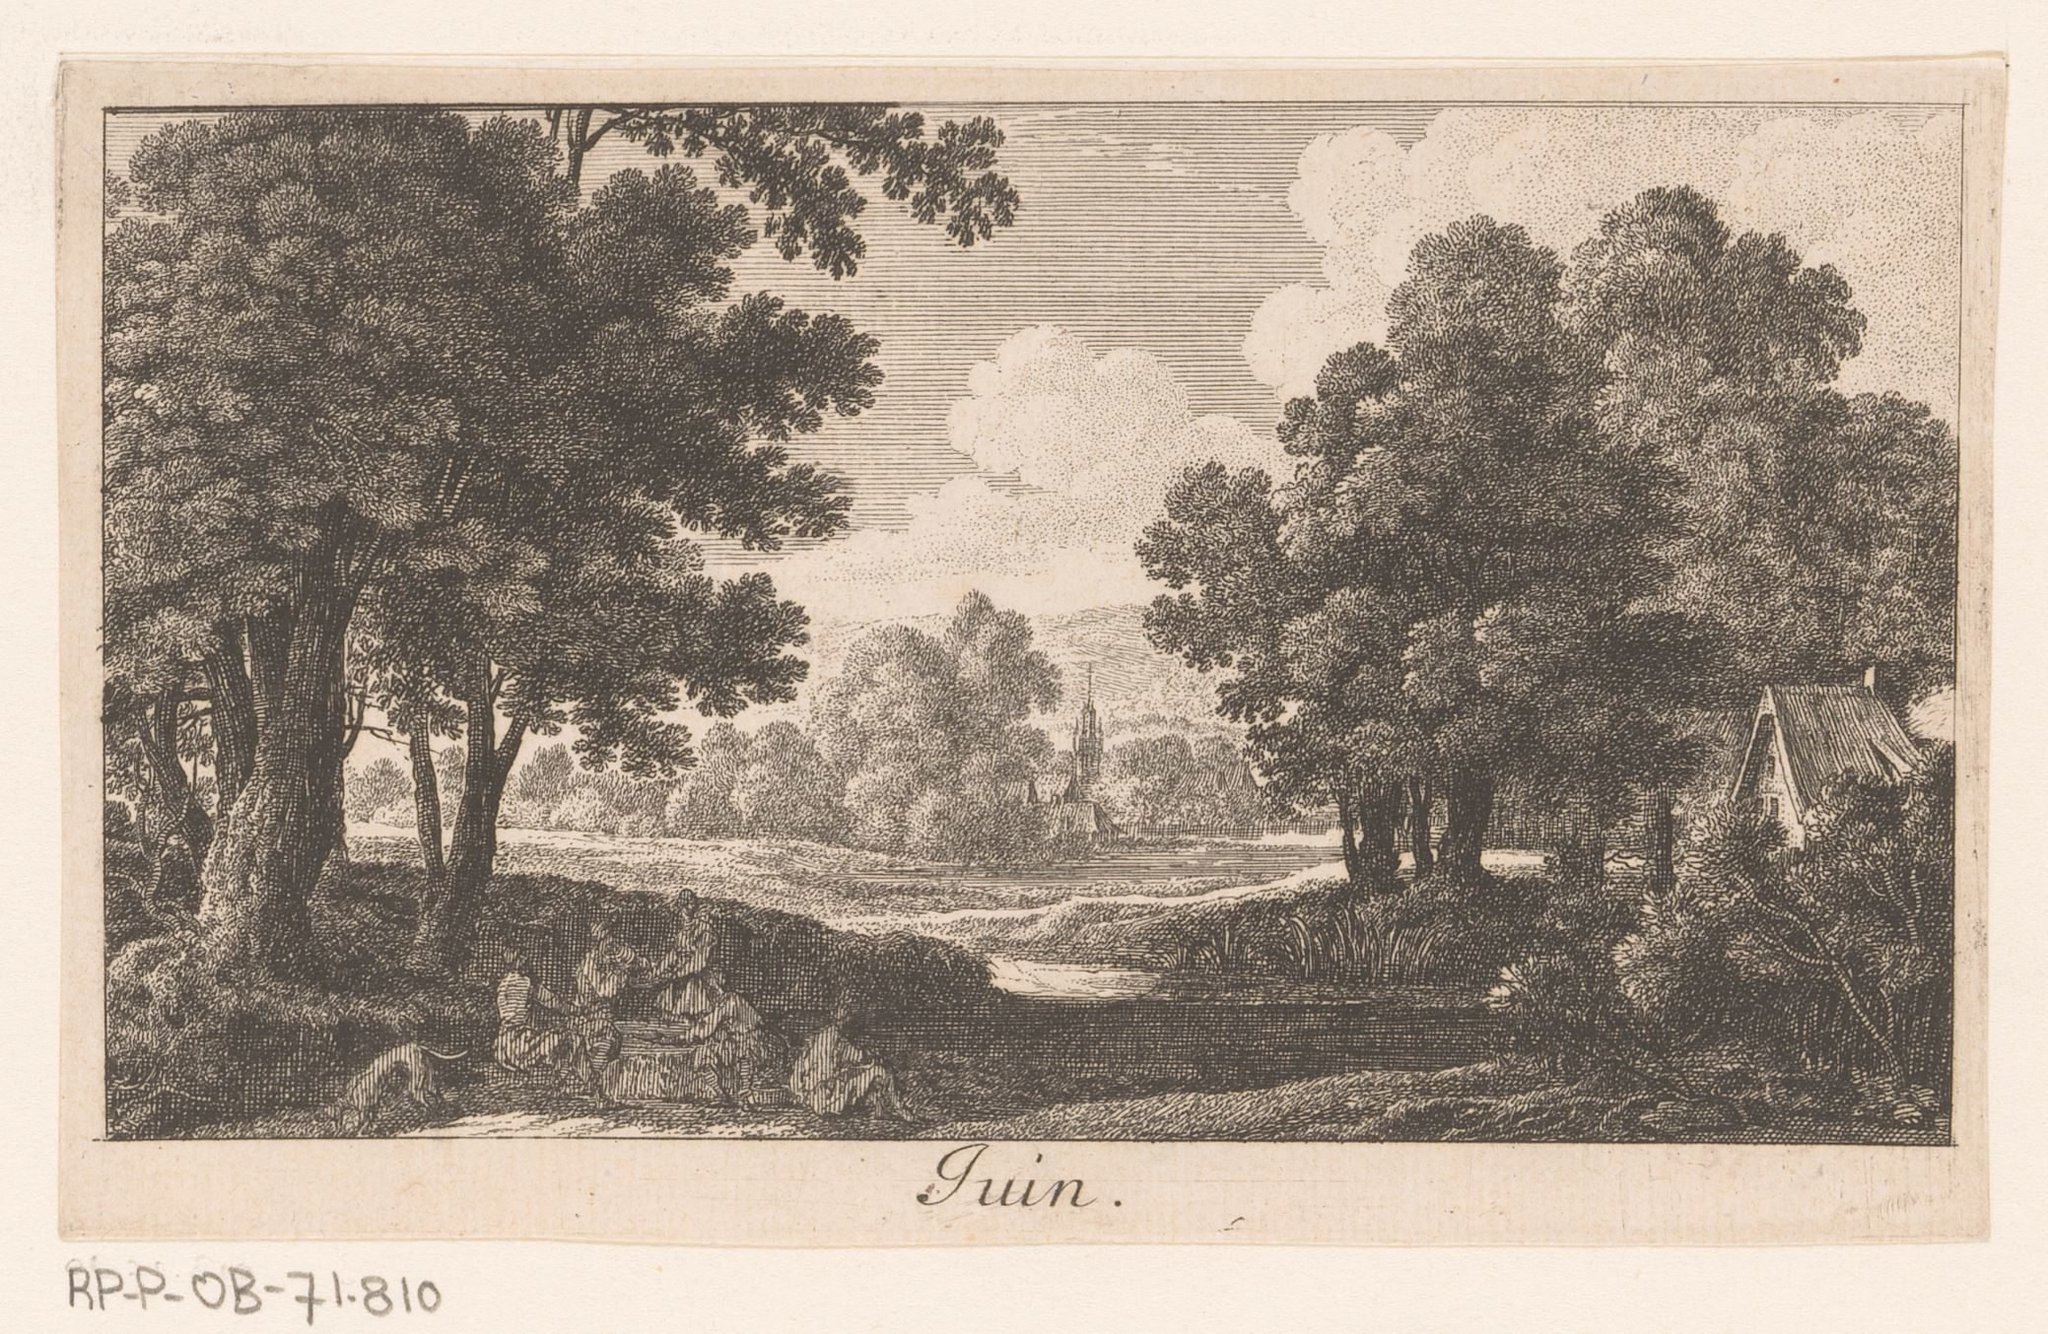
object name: print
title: Juin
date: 1613-1655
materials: paper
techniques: engraving, etching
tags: landscape symbolizing june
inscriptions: collector's mark: Lugt 240